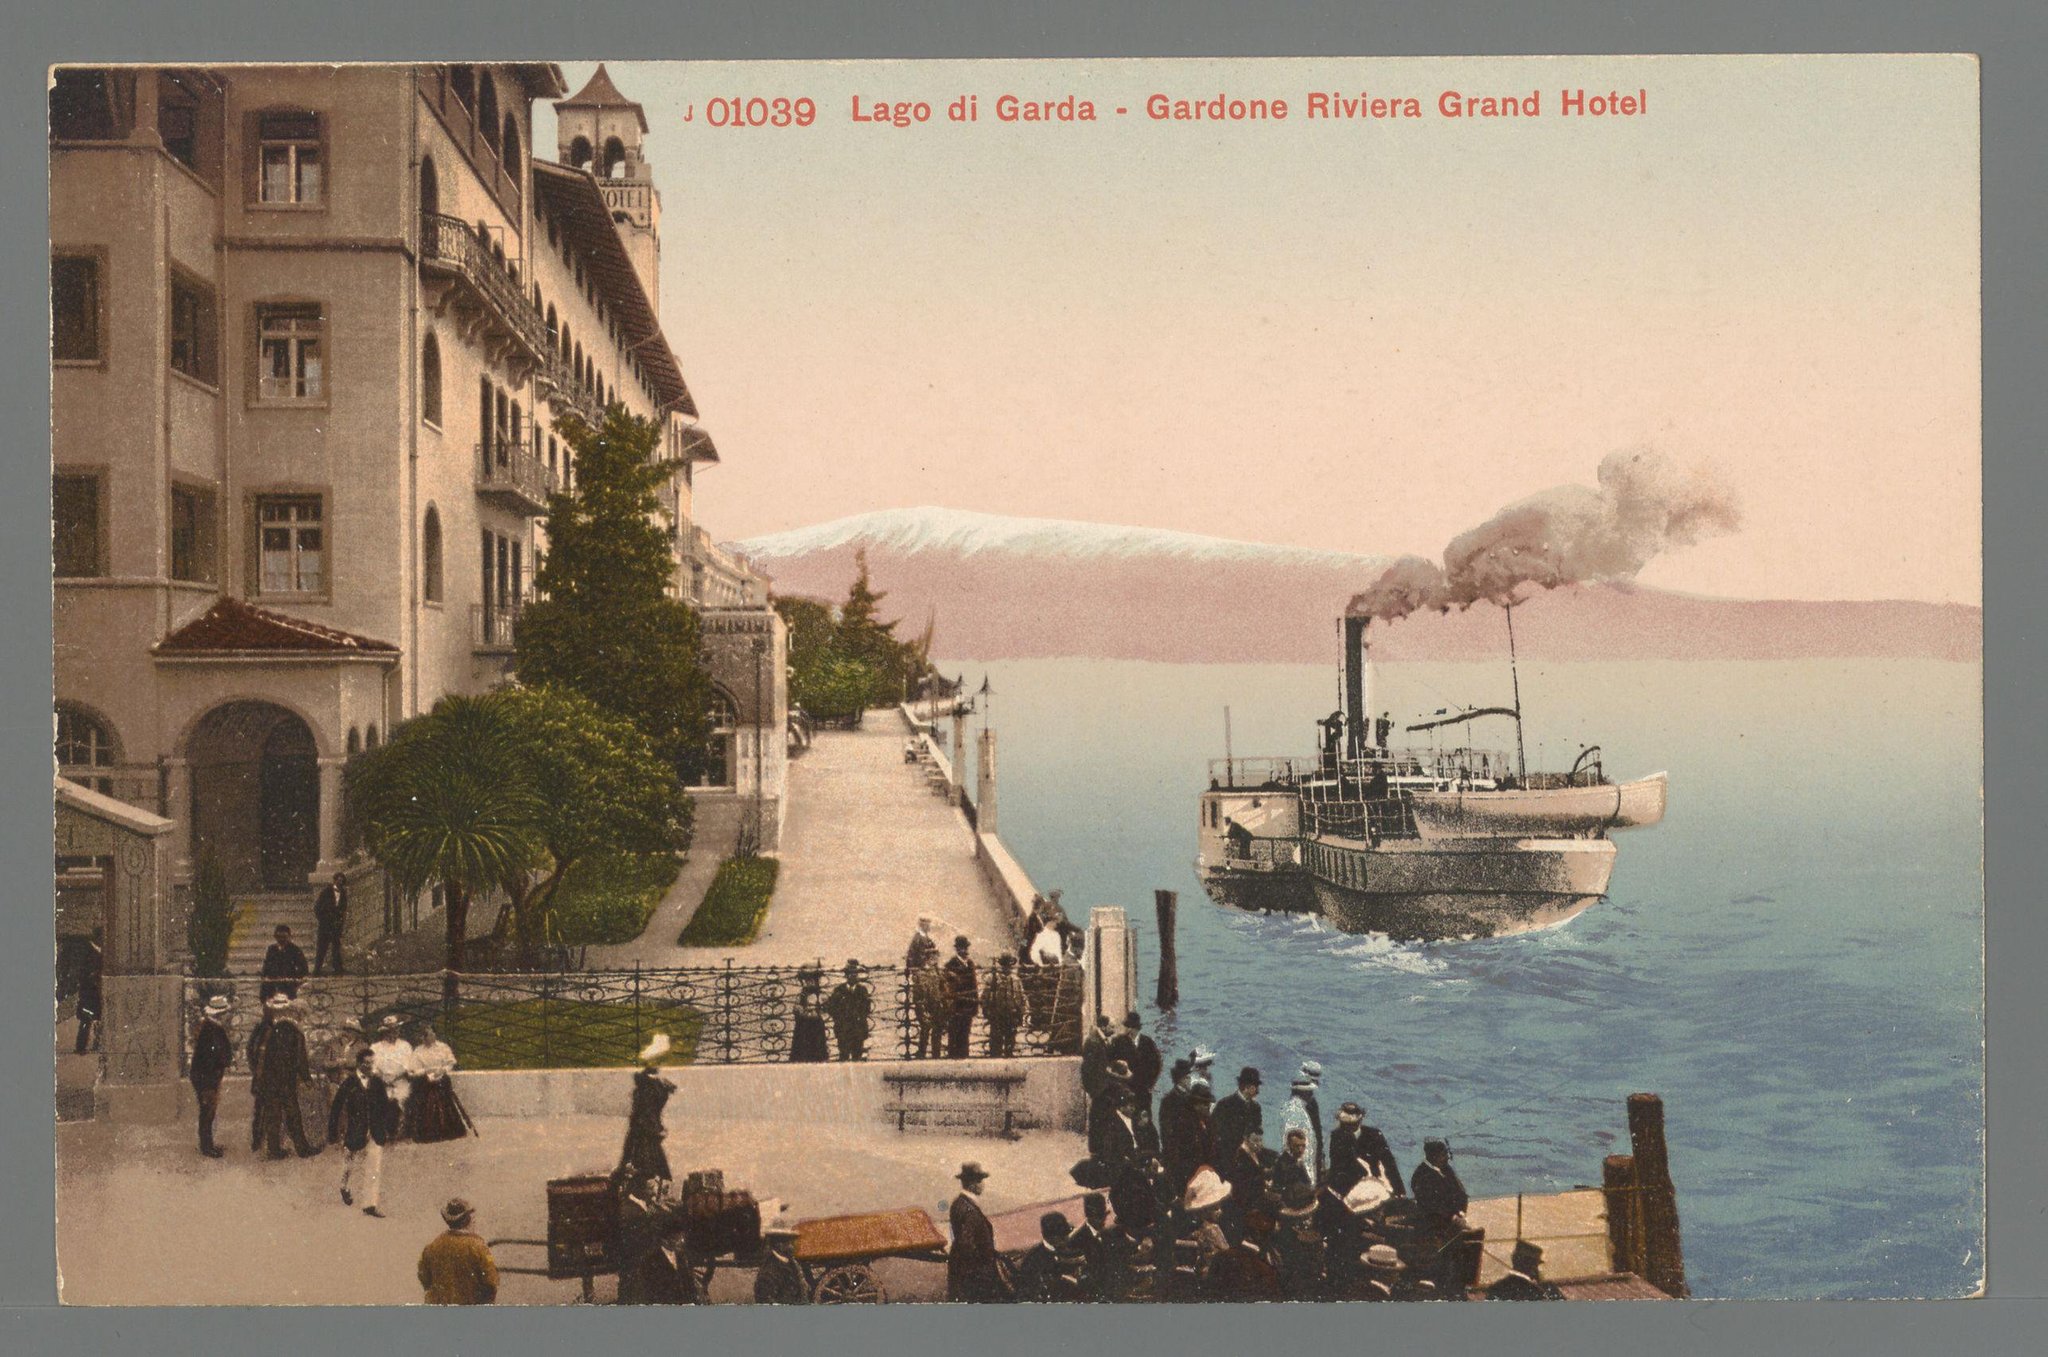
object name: ansichtkaart, prentbriefkaart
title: Lago di Garda. Gardone Riviera Grand Hotel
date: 1906-1928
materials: cardboard, photographic process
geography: toscolano-maderno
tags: ships (in general), lake, hotel, hostelry, inn